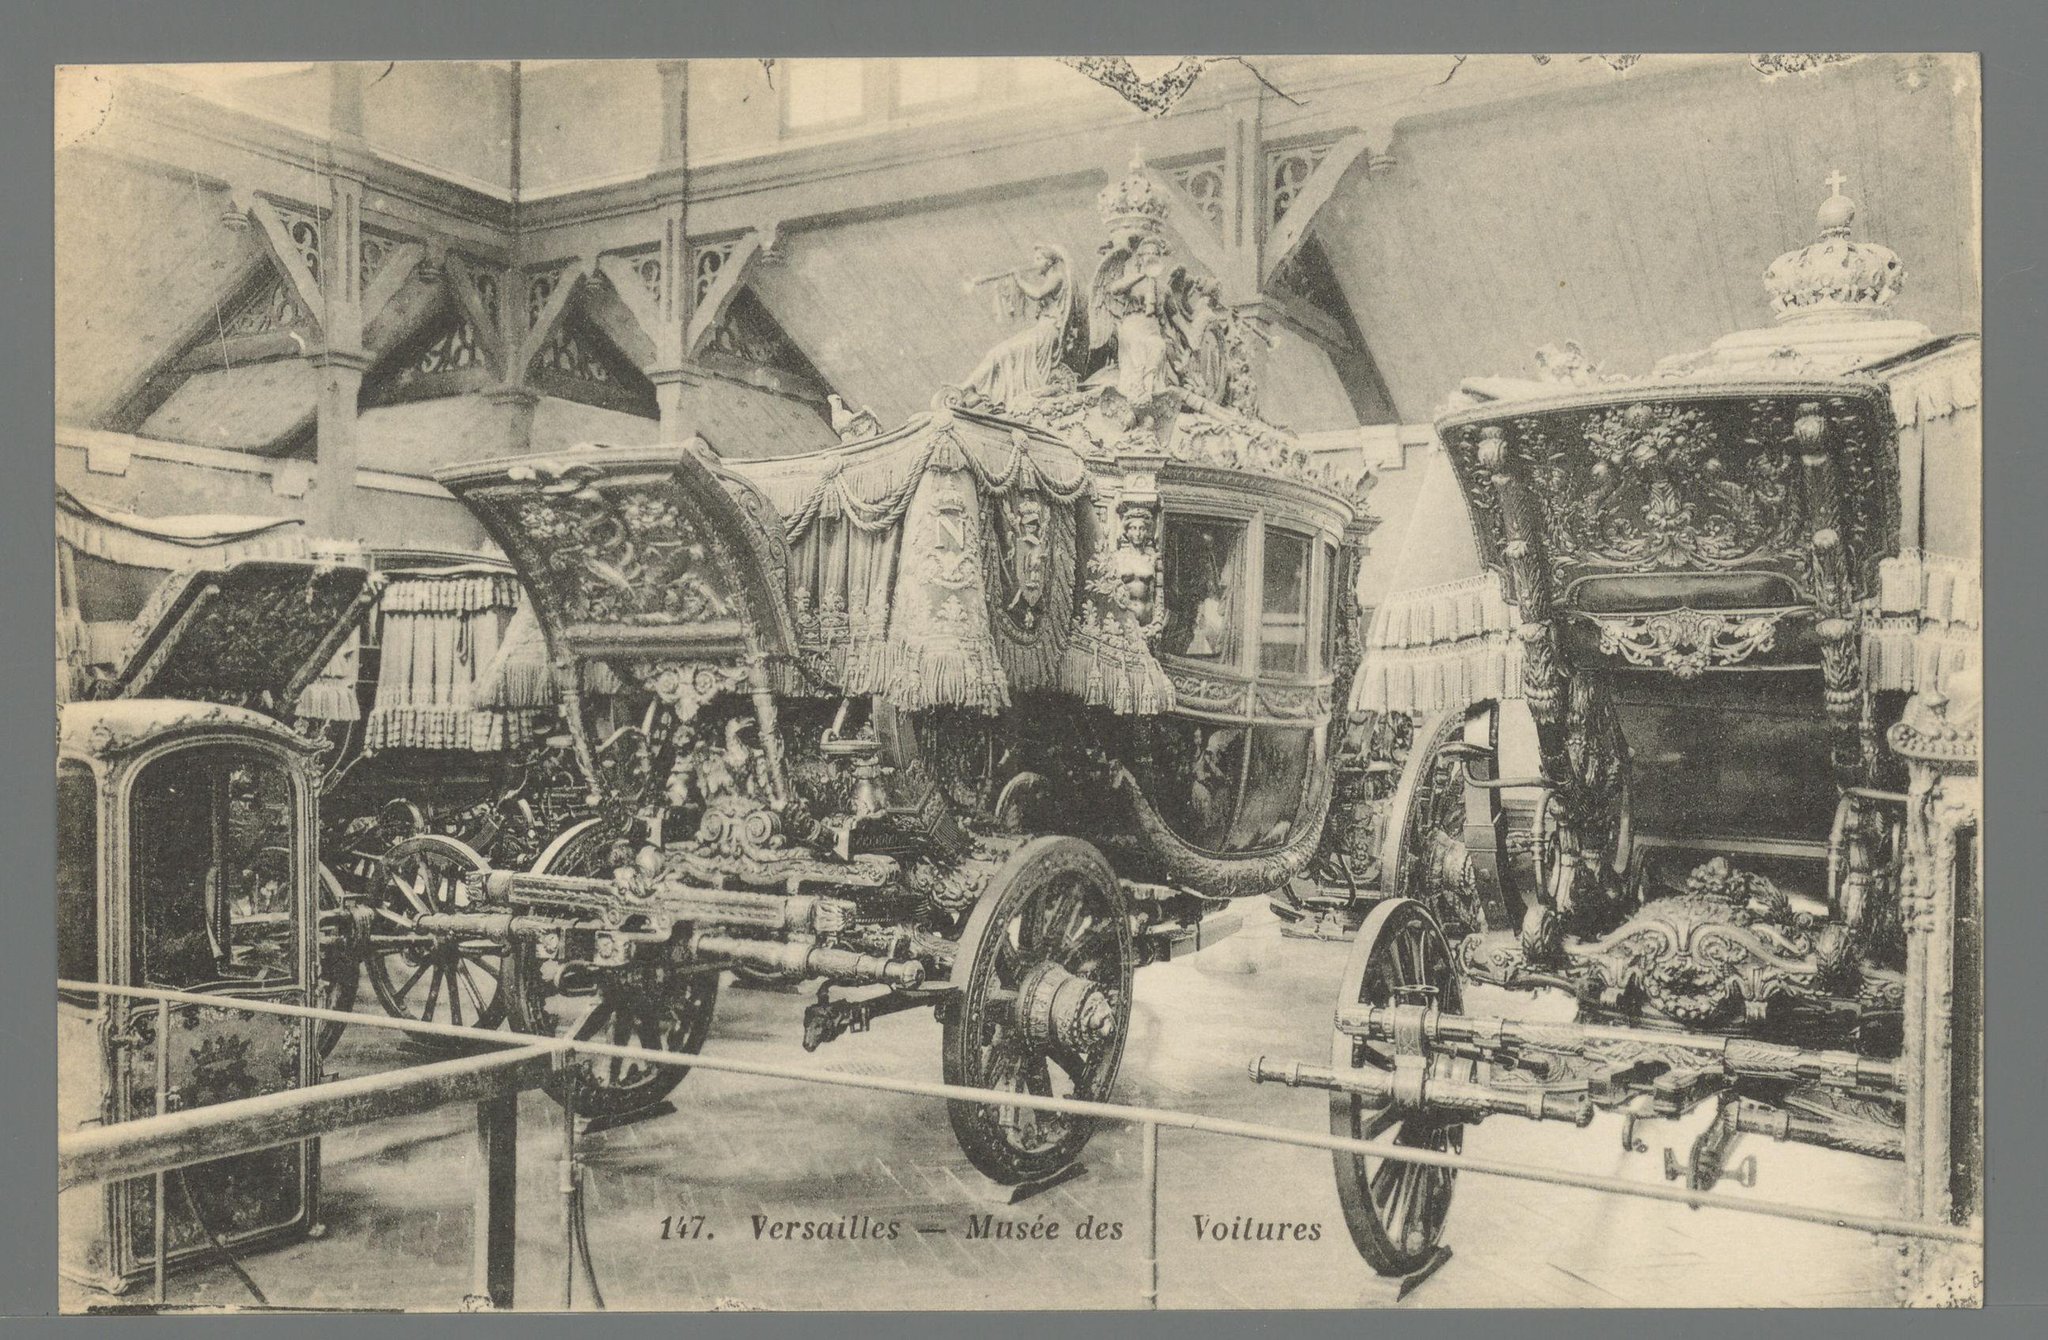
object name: photomechanical print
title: Versailles. Musée des Voitures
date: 1903-1920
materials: cardboard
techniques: photograph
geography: versailles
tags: four-wheeled, animal-drawn vehicle, e.g.: cab, carriage, coach, permanent exhibition, museum